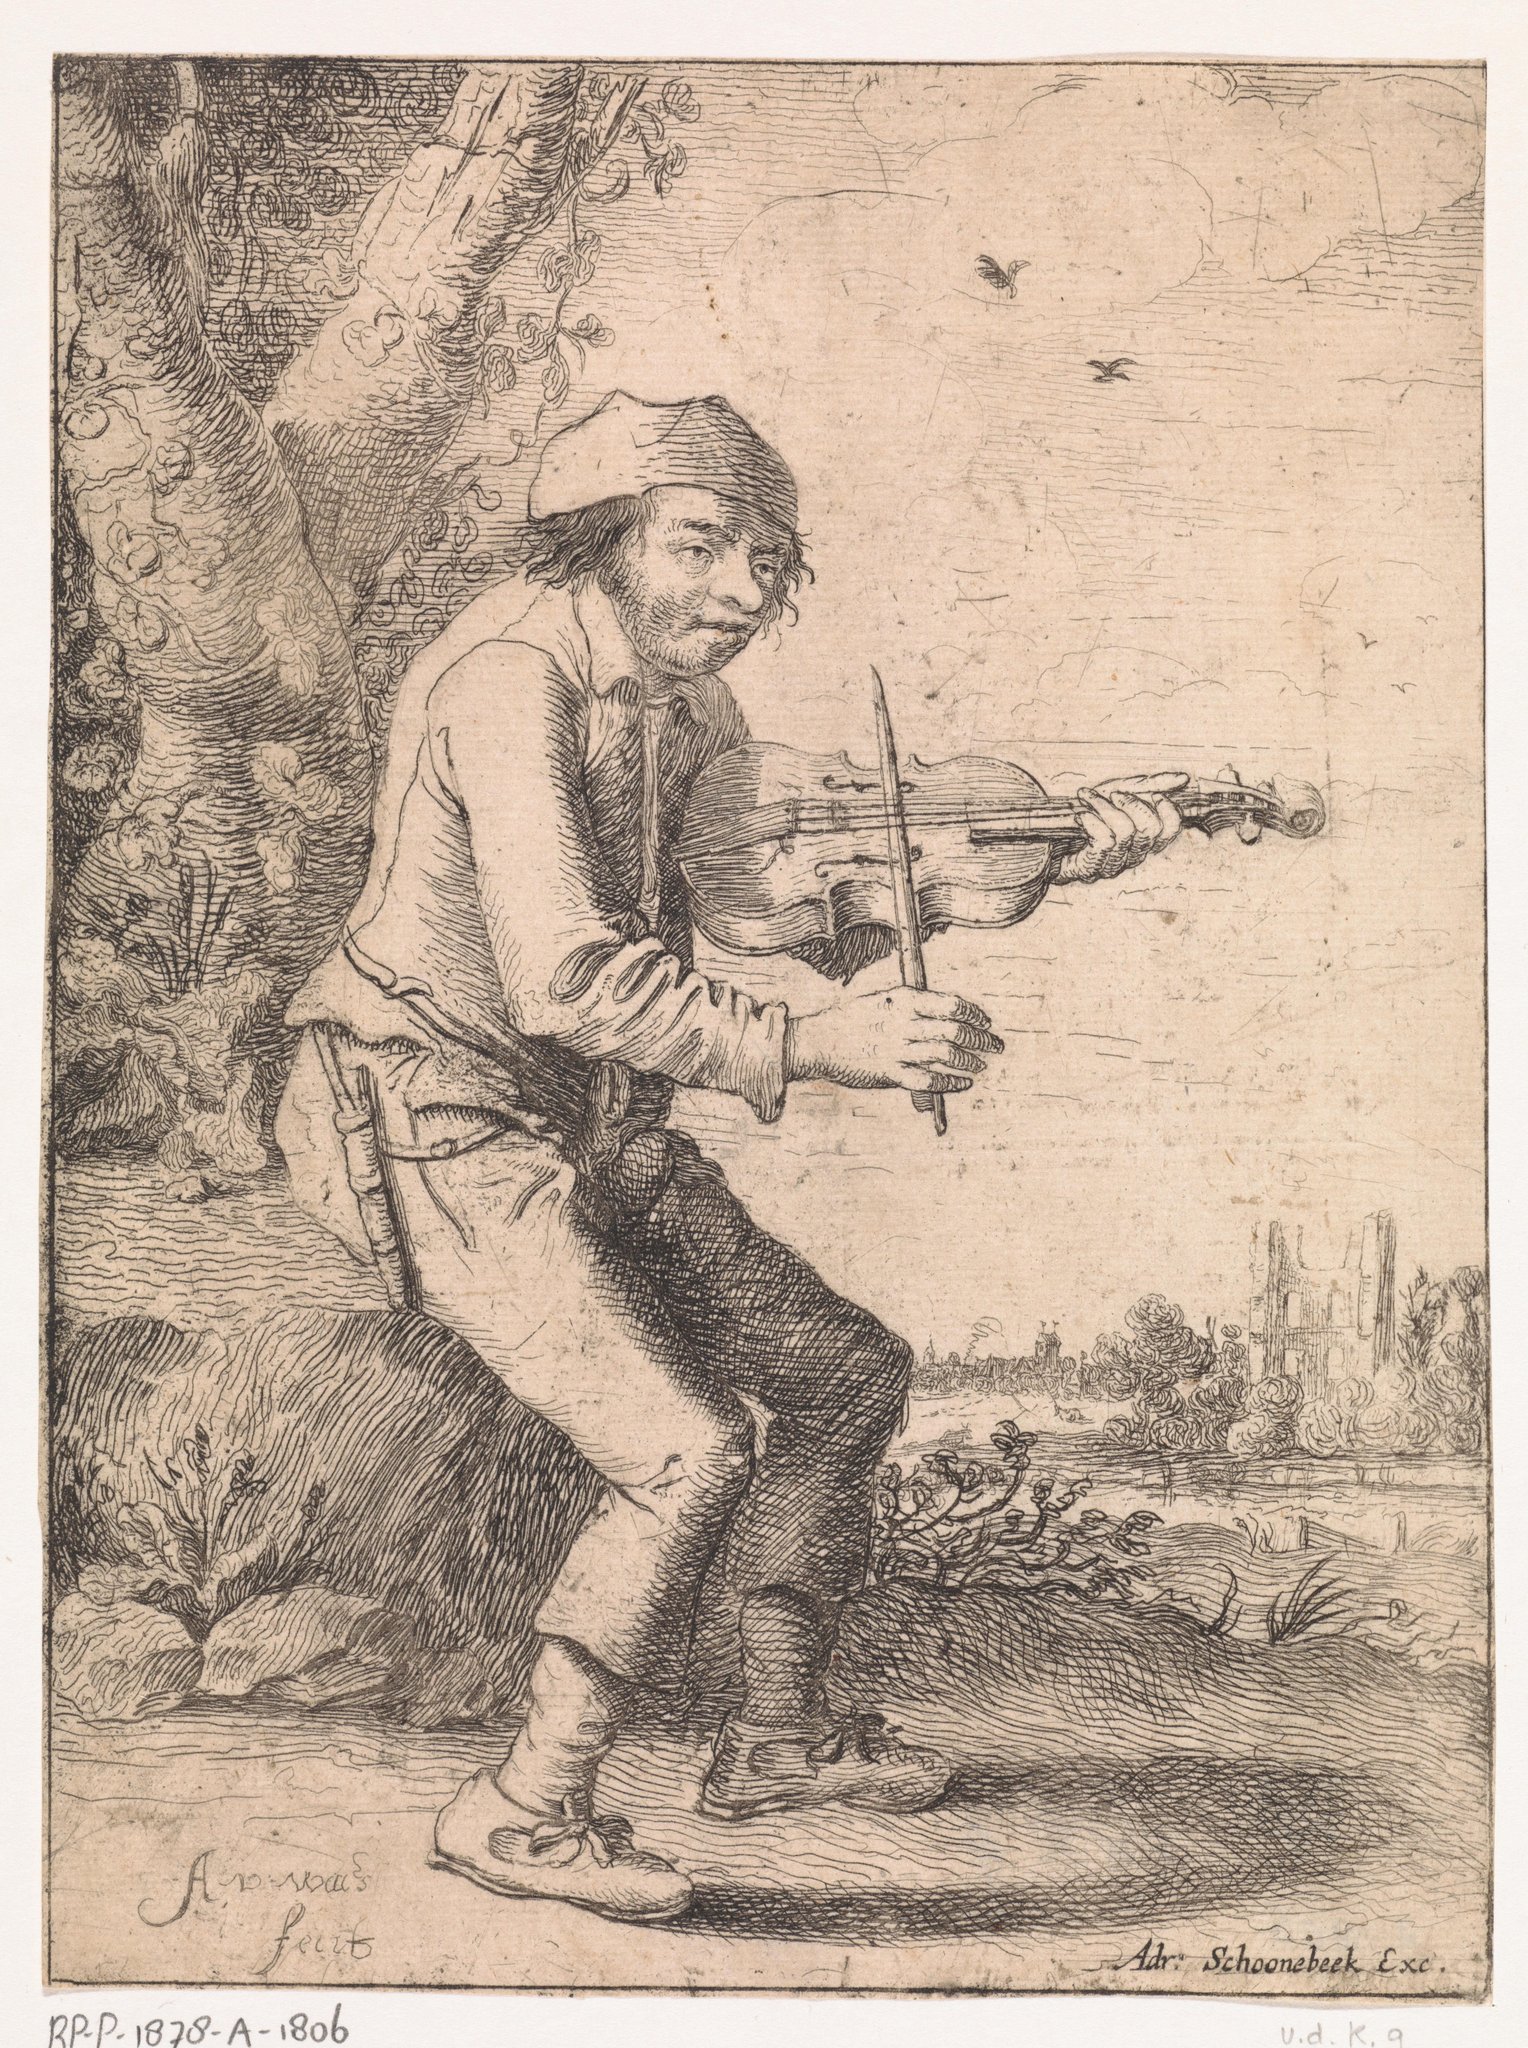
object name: print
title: De vioolspeler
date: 1639-1684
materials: paper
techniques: etching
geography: gouda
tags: violin, fiddle, landscape with ruins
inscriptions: collector's mark: Lugt 345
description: Landschap met een vioolspeler bij een boom.